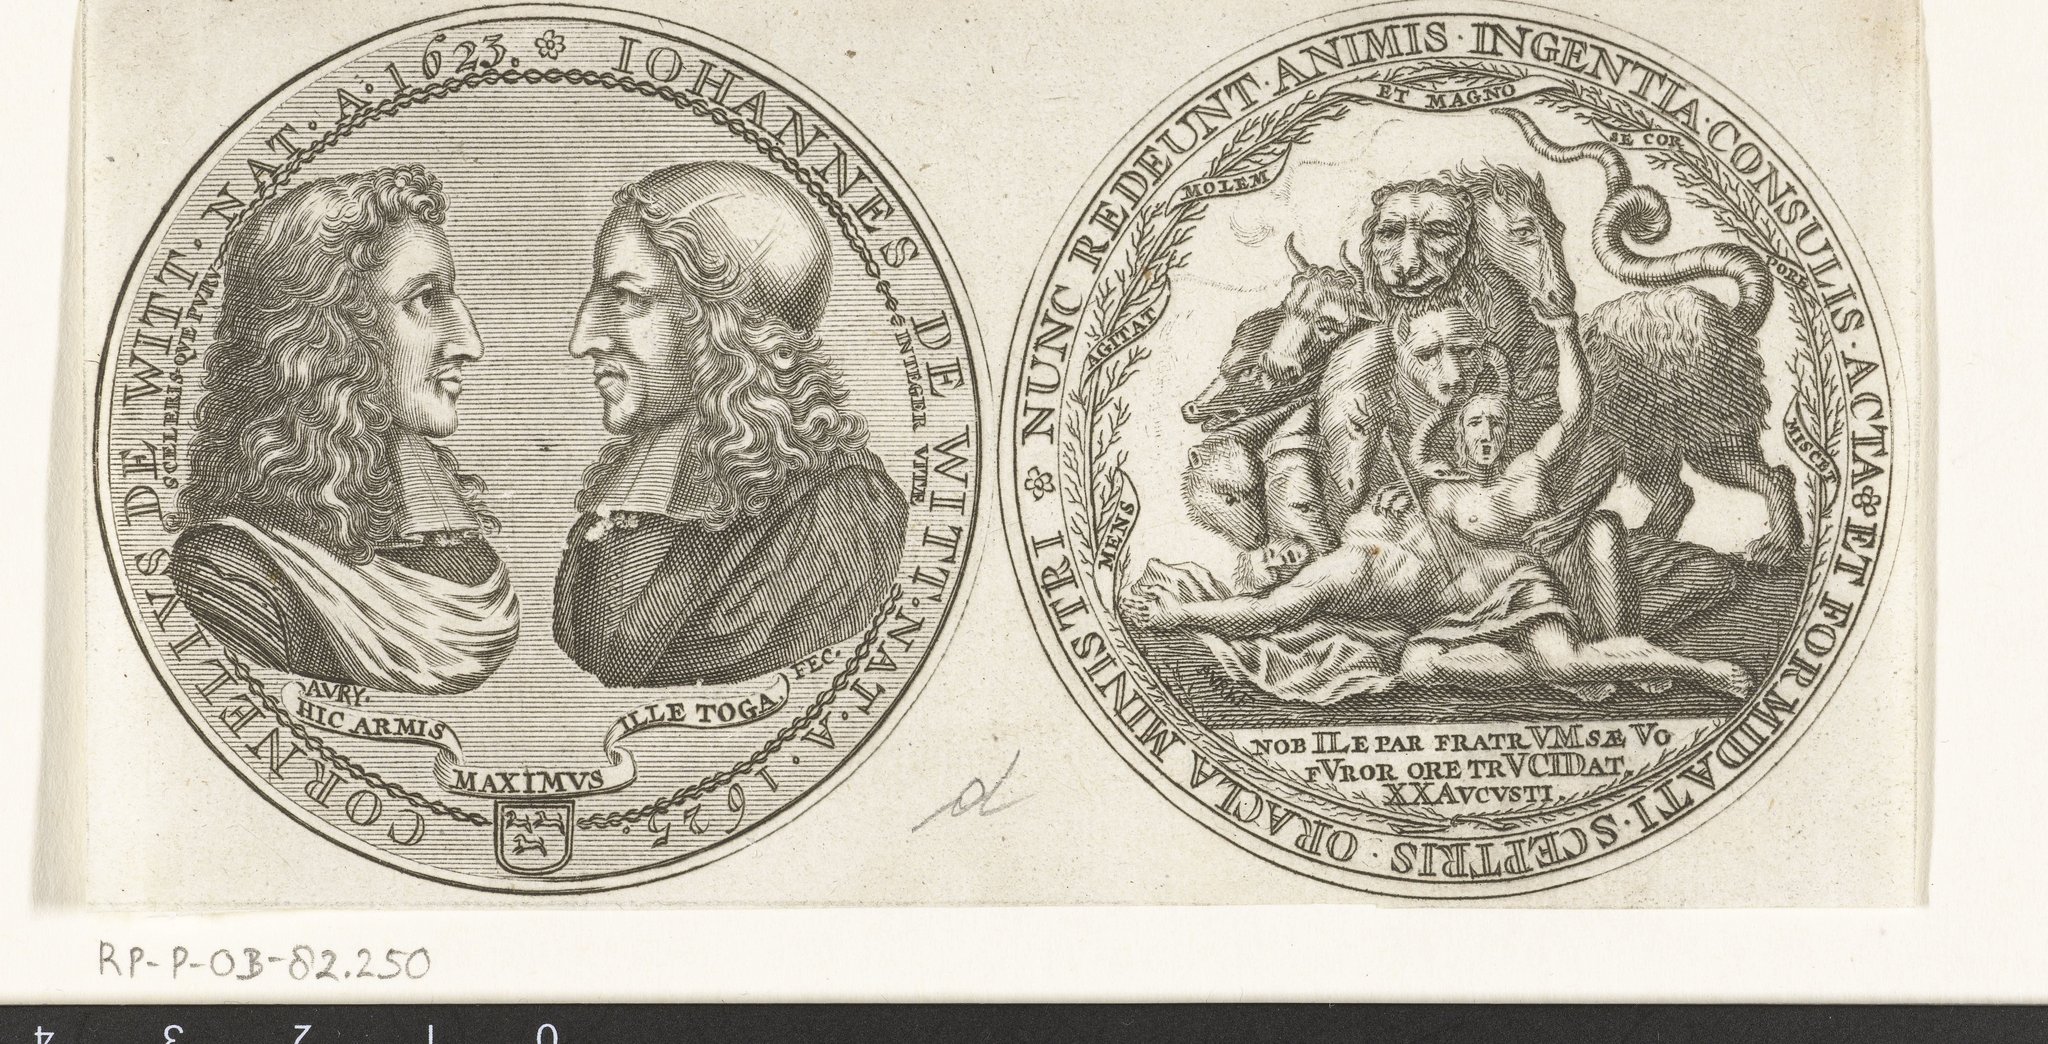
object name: historical object representation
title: Penning op de dood van de gebroeders De Witt, 1672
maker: Anonymous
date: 1672-1699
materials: paper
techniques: engraving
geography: northern netherlands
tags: dordrecht, the hague, cornelis de witt, politician, johan de witt, medal (considered as a piece of sculpture, regardless of its specific function)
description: Voor- en keerzijde van een penning met de portretten van de gebroeders Johan en Cornelis de Witt, en een allegorische voorstelling van de dood van de gebroeders Johan en Cornelis de Witt, vermoord op 20 augustus 1672, waarin de broers worden aangevallen door een beest met vele koppen, symbool van het volk dat de lichamen verminkte.